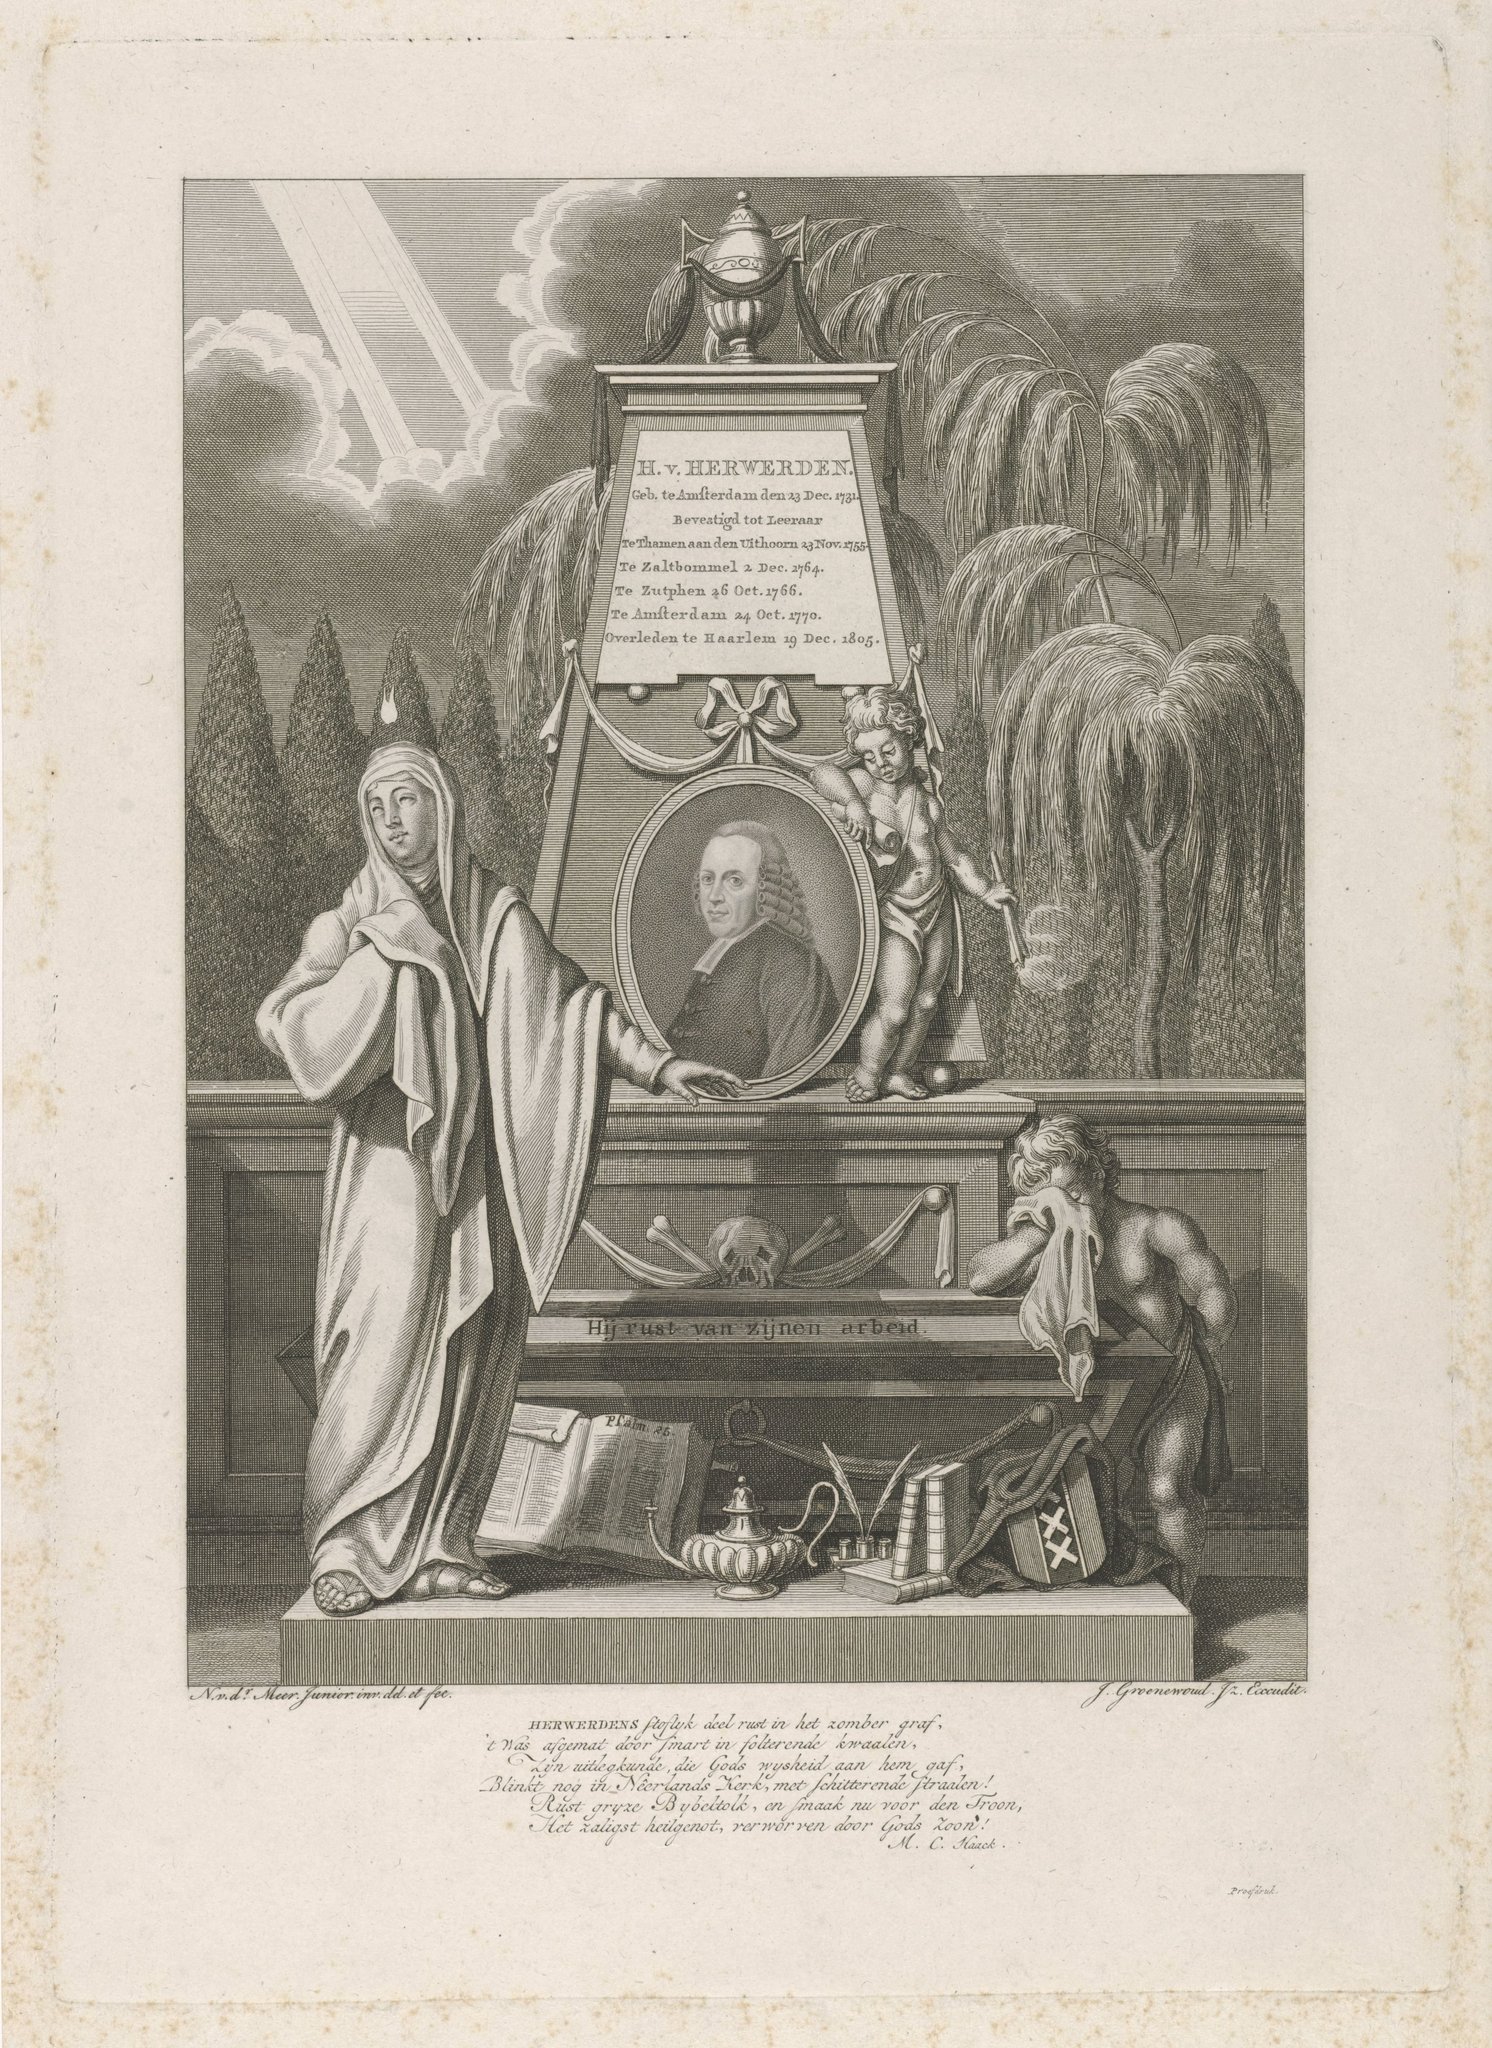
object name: print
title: Gedenkteken voor Henricus van Herwerden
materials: paper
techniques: engraving, etching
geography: amsterdam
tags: faith, 'fides'; 'fede', 'fede catholica', 'fede christiana', 'fede christiana catholica' (ripa) ~ one of the three theological virtues (+ variant), torch - bb - torch held upside down, historical persons, book, the bible as a book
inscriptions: collector's mark: Lugt 2228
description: Gedenkteken voor predikant Henricus van Herwerden. Naast zijn portret staat een putto met een omgekeerde fakkel in de hand. Aan weerszijden van de sarcofaag staan Geloof, met een vlam op haar hoofd, en een treurende putto. Op de grond een opengeslagen bijbel, een lamp, schrijfgerei, boeken en het wapen van Amsterdam. Over de voorstelling een zesregelig vers in het Nederlands.